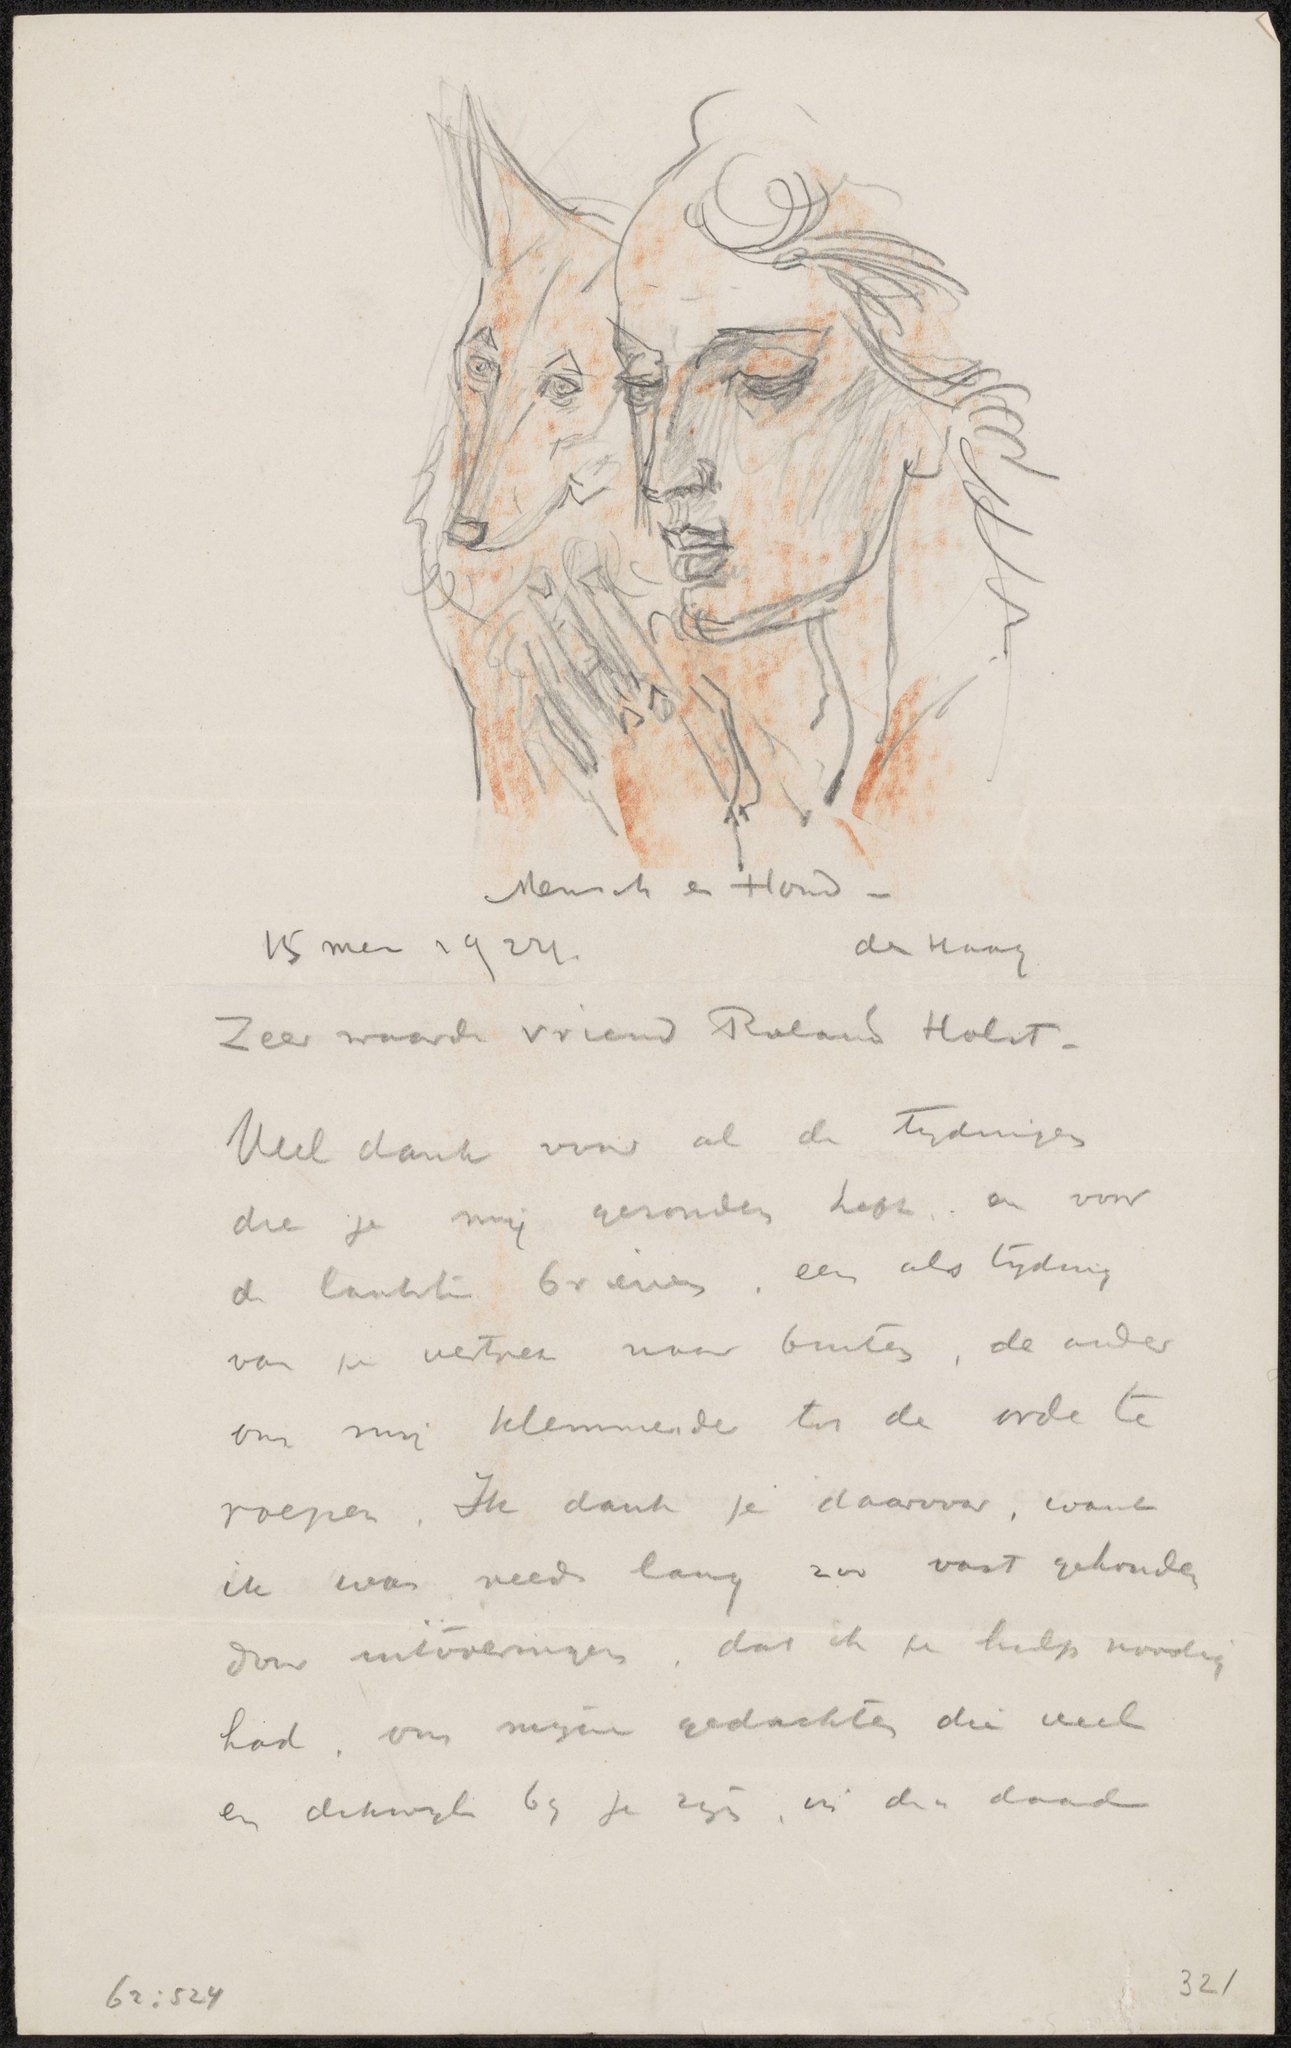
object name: letter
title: Brief aan Richard Roland Holst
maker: willem van konijnenburg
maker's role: draughtsman, painter, print maker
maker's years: 1868-1943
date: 1924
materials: chalk, ink, paper, pencil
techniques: writing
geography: the hague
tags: jan mankes, richard nicolaüs roland holst, head (human), the graphic arts, dog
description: Vormt doorlopende brief met RP-T-1962-525.